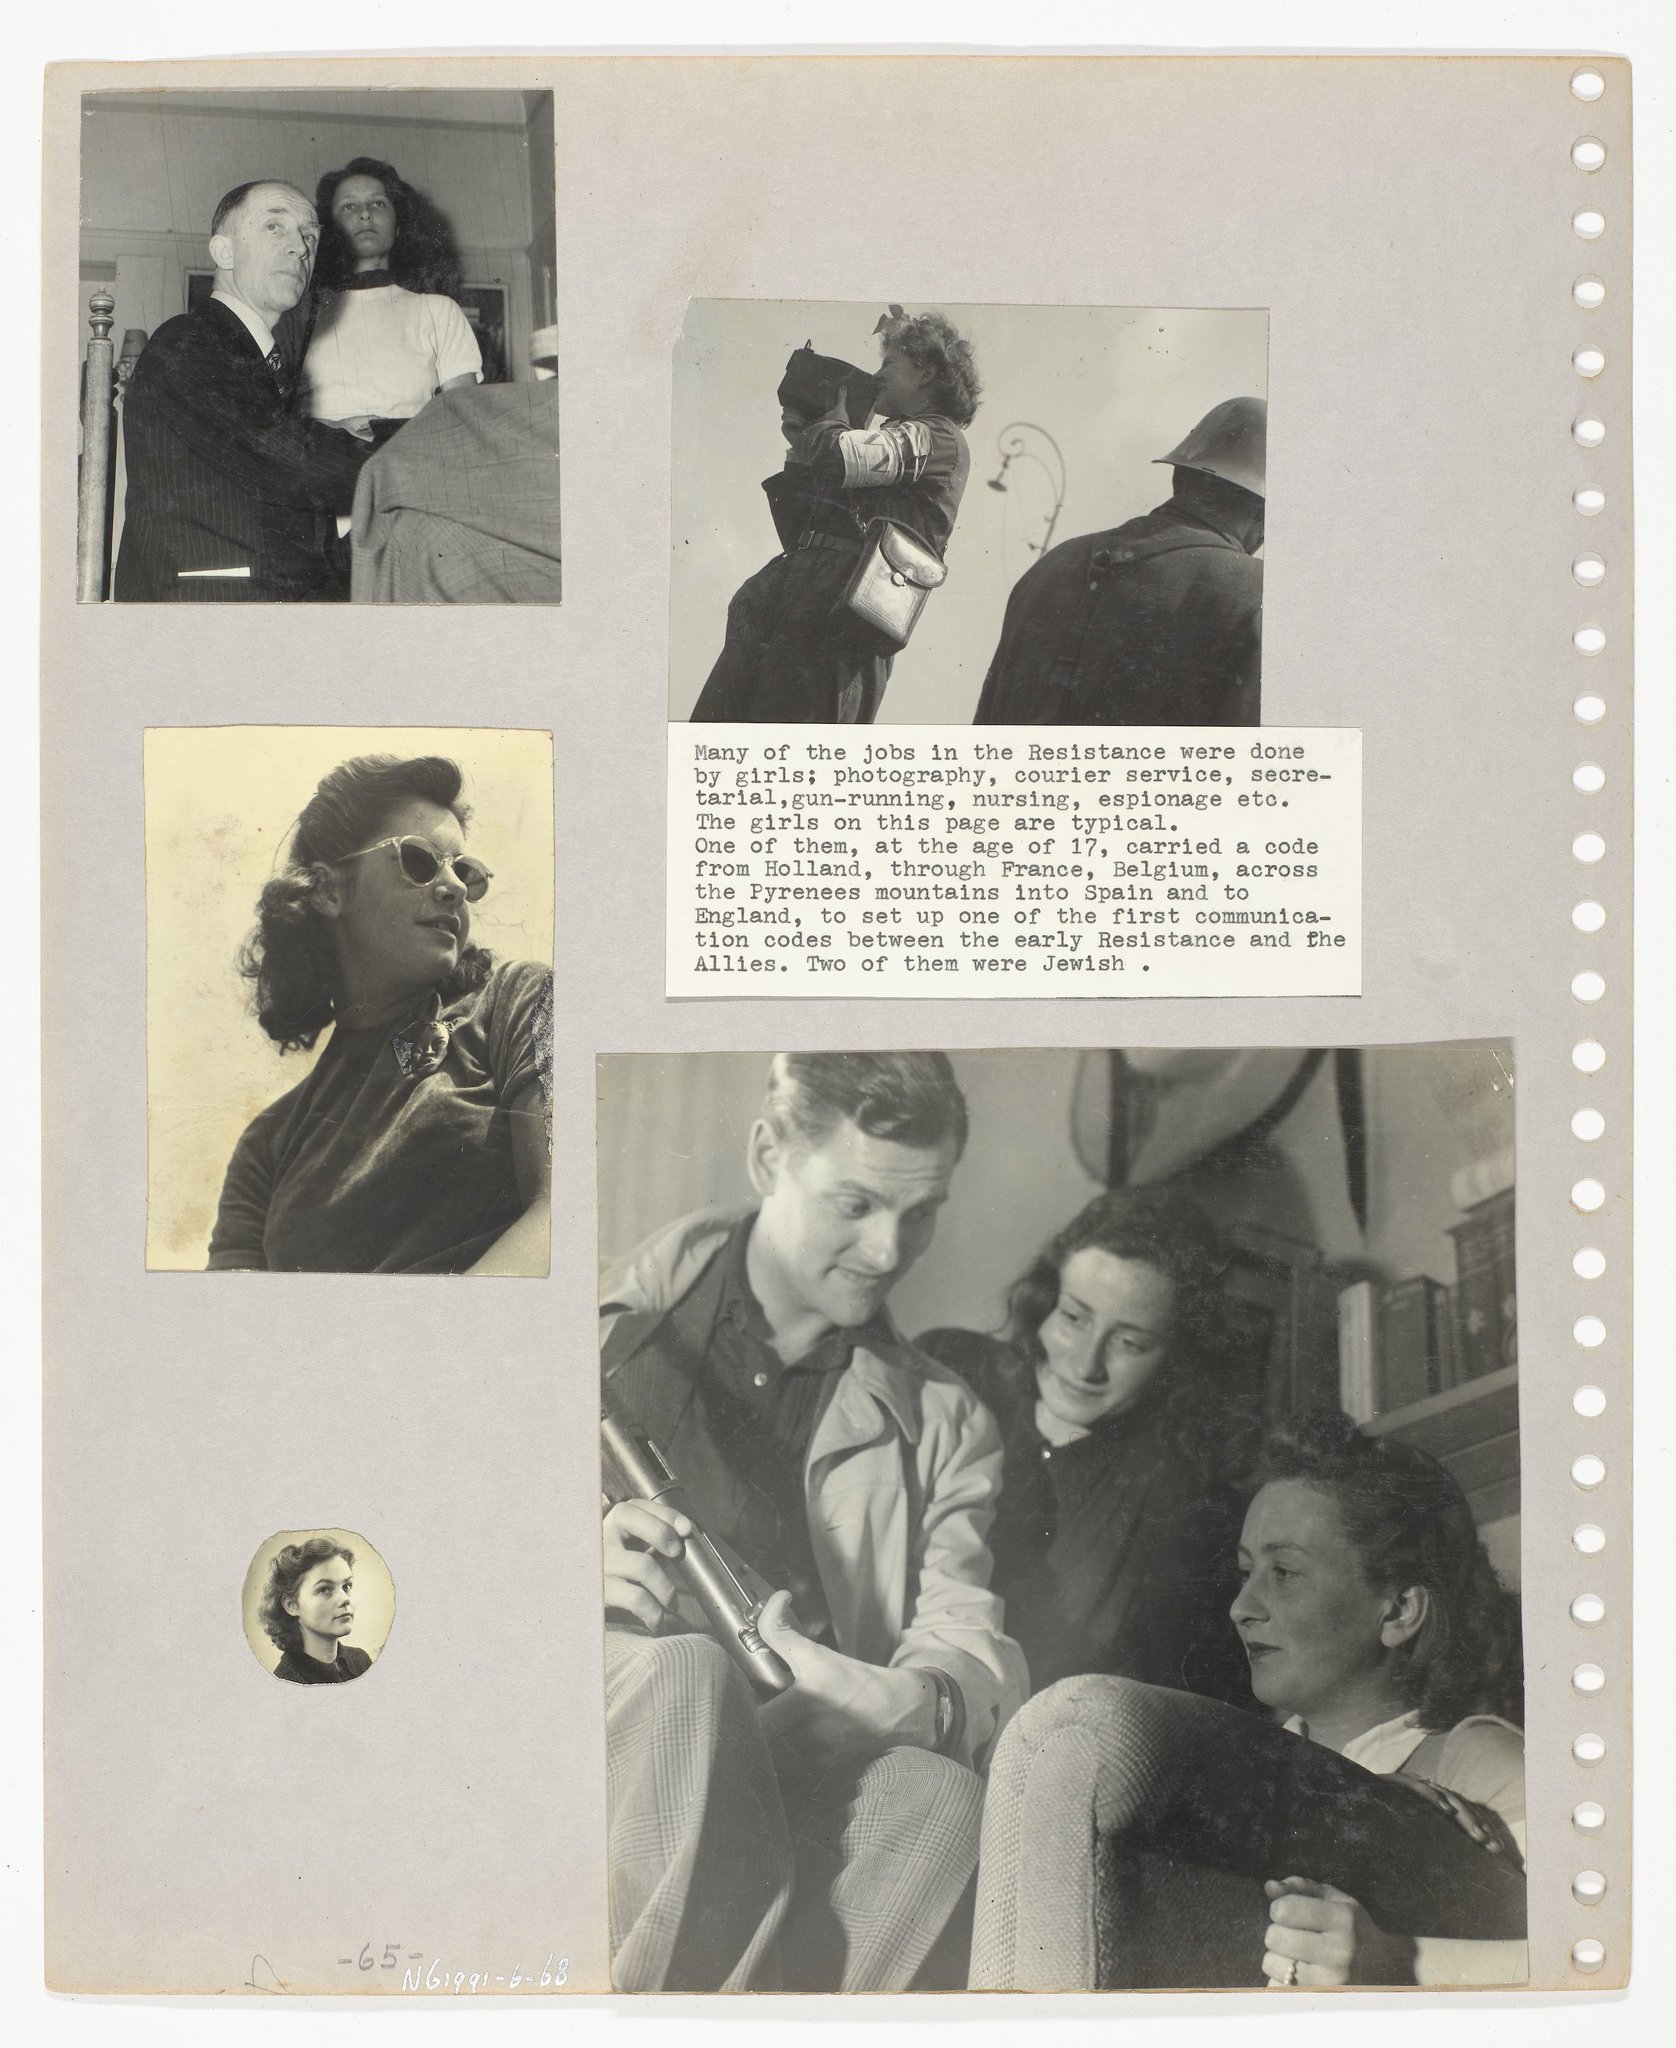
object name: photograph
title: Foto en collageboek 'De Verborgen Camera'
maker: Anonymous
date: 1944-1945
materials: paper, plastic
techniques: photography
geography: netherlands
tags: amsterdam, tonny van renterghem, berlin, fritz kahlenberg, underground movement, partisans, netherlands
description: Vijf foto's met betrekking tot het werk van koeriersters. Lb. koerierster met majoor J.H. Claus. Daaronder twee portretten van koeriersters. Rb. vrouw met camera en band om haar arm met V.V. naast haar een lid van de BS. (Foto gemaakt tijdens bevrijding ca. 8 mei). Onder r. Tony van Renthergem met een wapen en twee koeriersters.